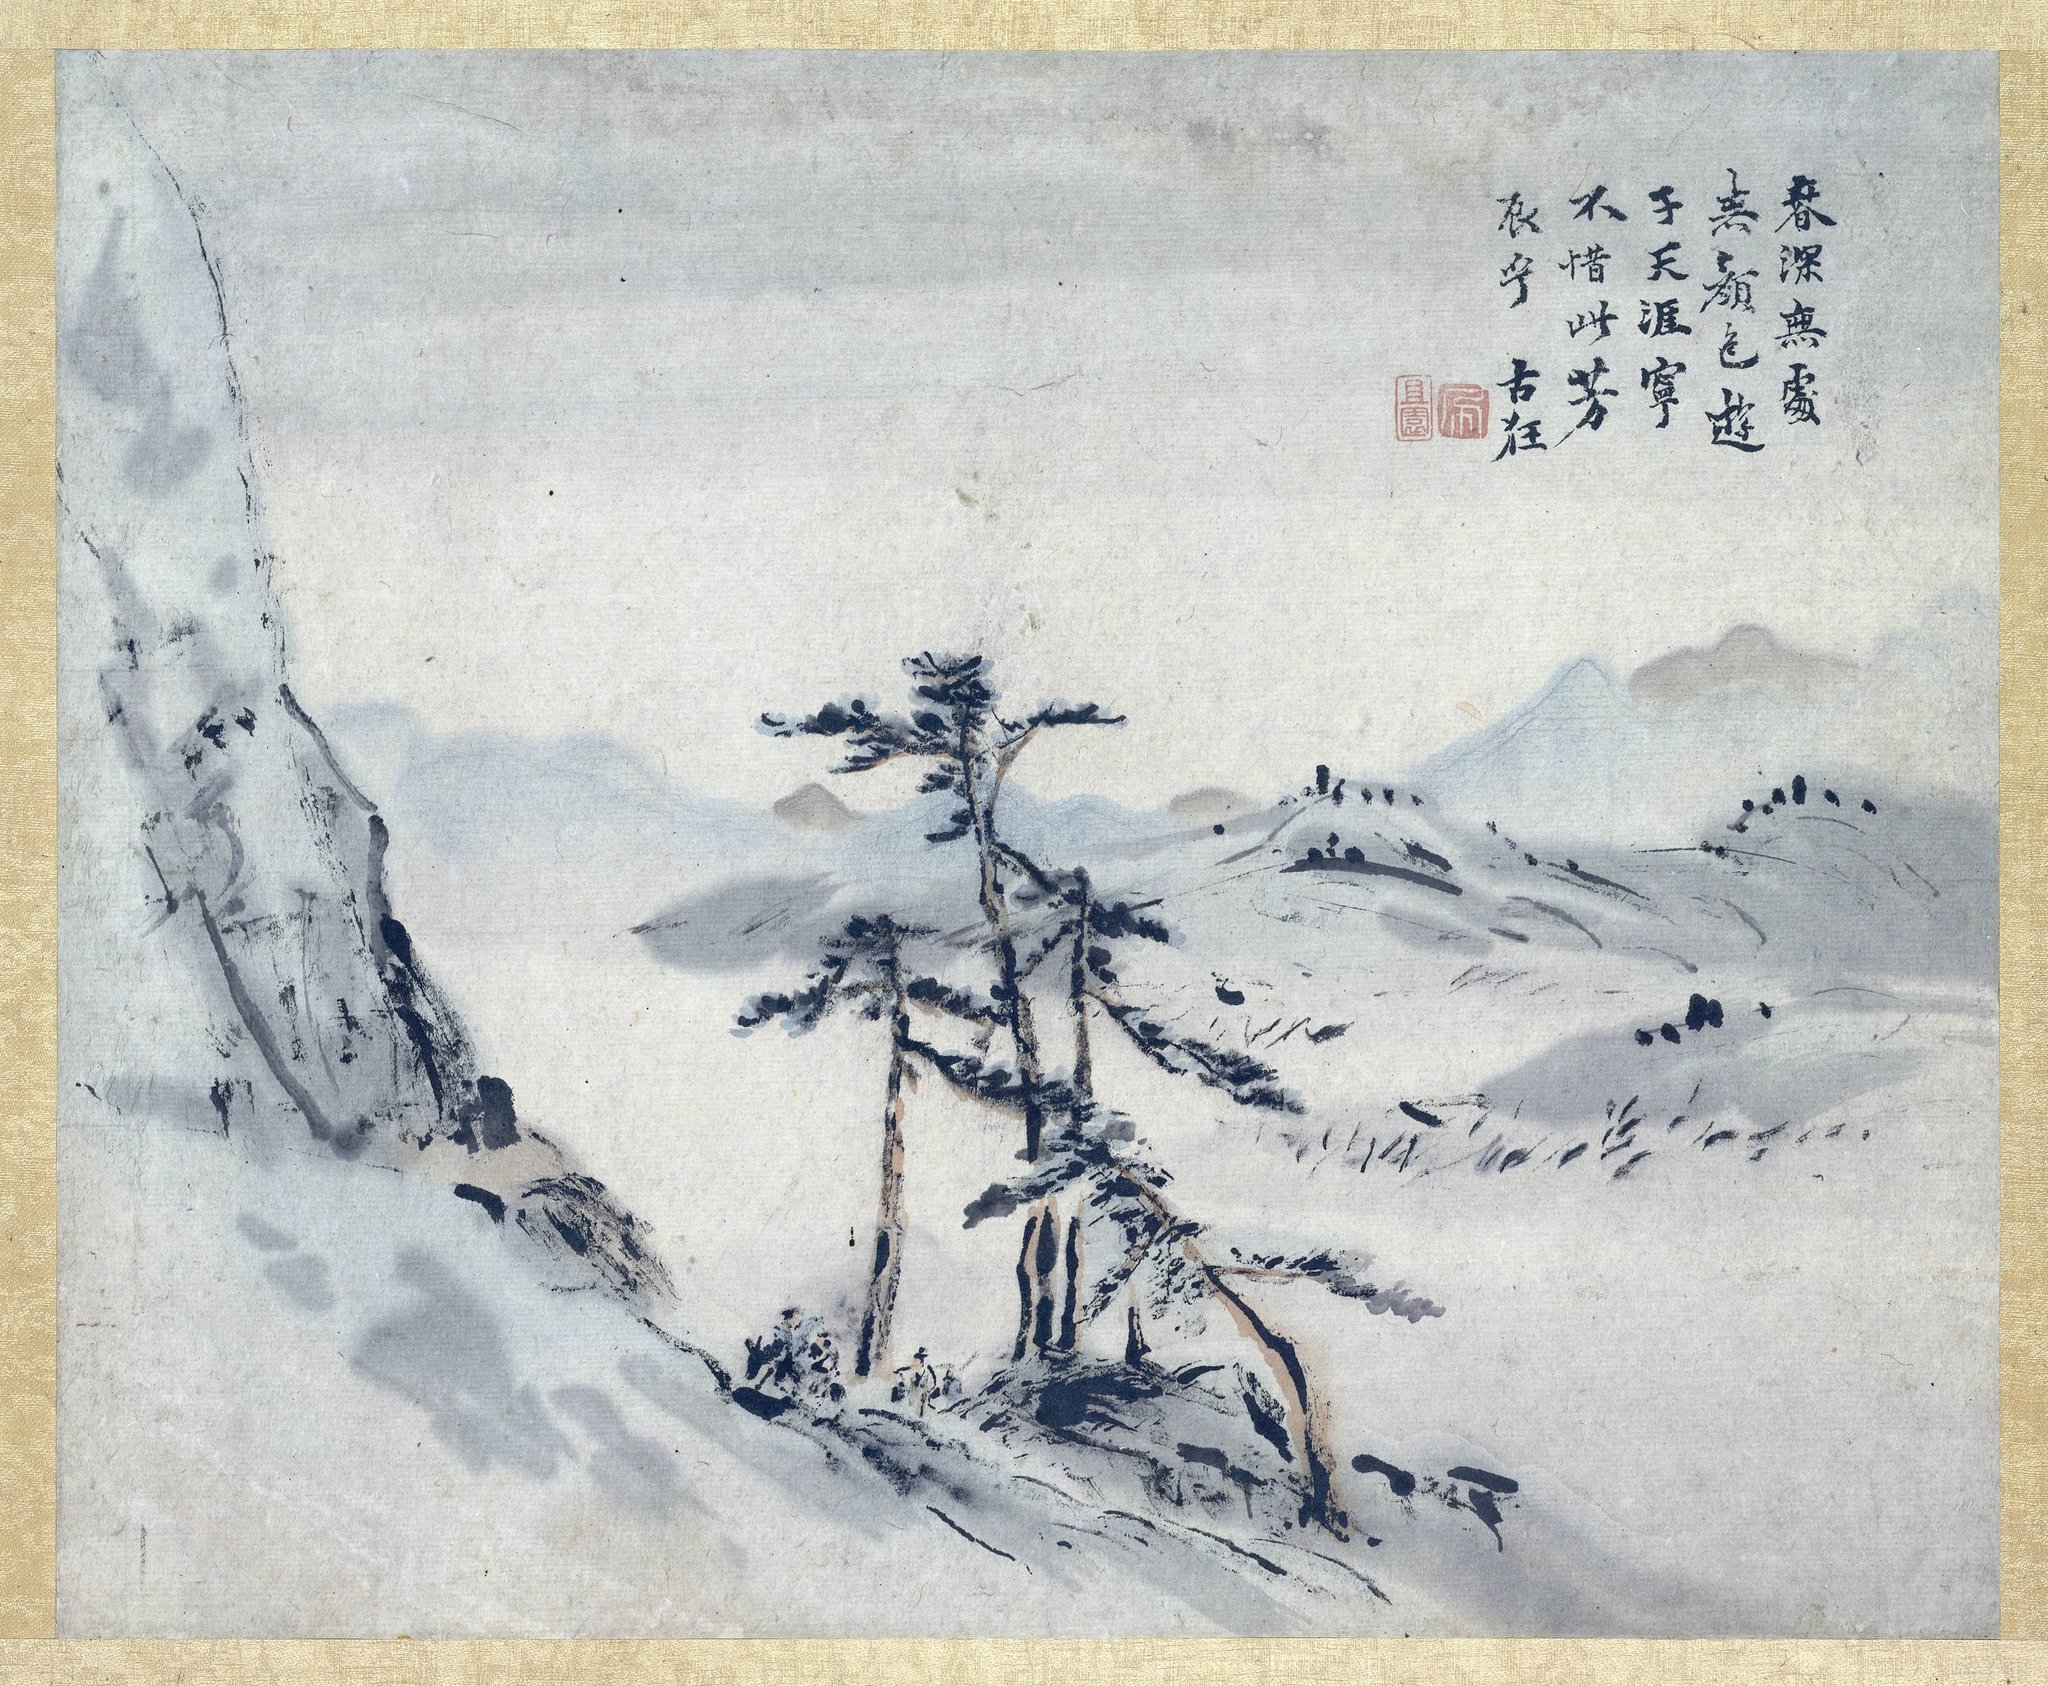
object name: finger painting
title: Schildering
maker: gao qipei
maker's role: painter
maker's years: 1661-1734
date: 1700-1750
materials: dye, ink, paper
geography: china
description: Eén van twaalf landschappen, vingerschildering met opschrift van de schilder Gao Qipei (1662 - 1731(?)). Opmerking: Zie inv. nr. AK-MAK-290.